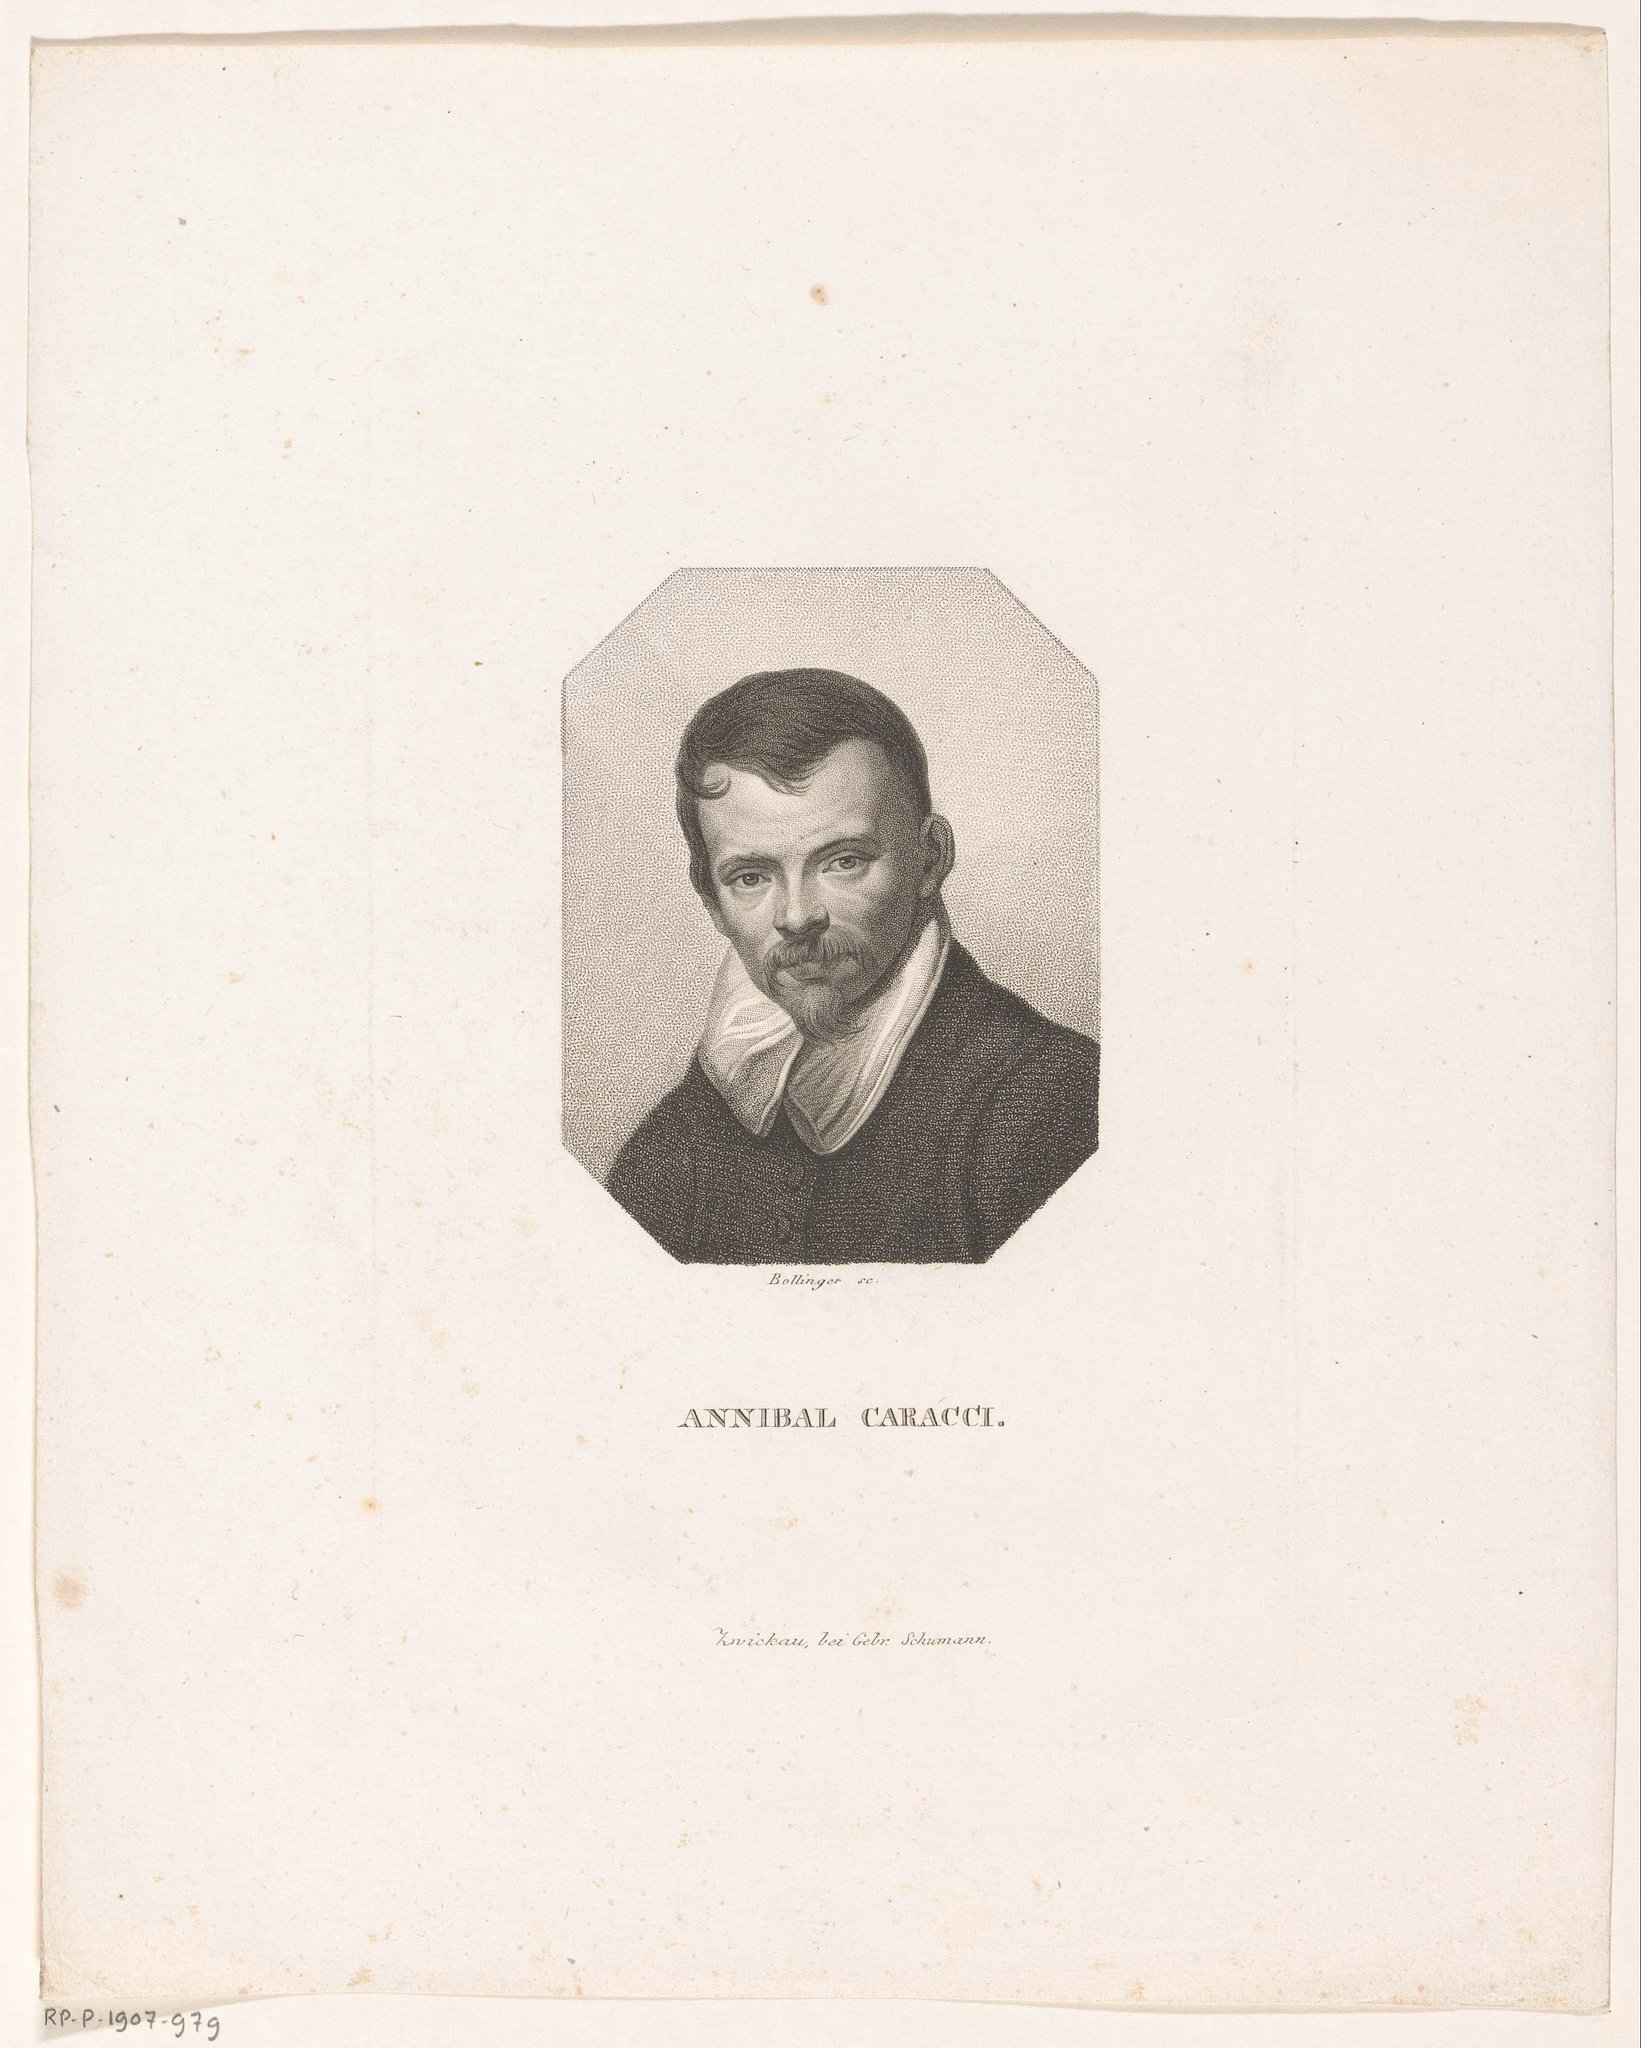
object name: print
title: Bildnisse der berühmtesten Menschen aller Völker und Zeiten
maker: friedrich wilhelm bollinger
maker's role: print maker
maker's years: 1777-1825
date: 1818-1832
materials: paper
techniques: stippling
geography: berlin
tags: rome, annibale carracci, historical persons, portrait, self-portrait of artist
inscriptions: collector's mark: Lugt 2228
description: Prent gebruikt door de serie 'Bildnisse der berühmtesten Menschen aller Völker und Zeiten' van de gebroeders Schumann, uitgegeven in 1818-1832 te Zwickau.